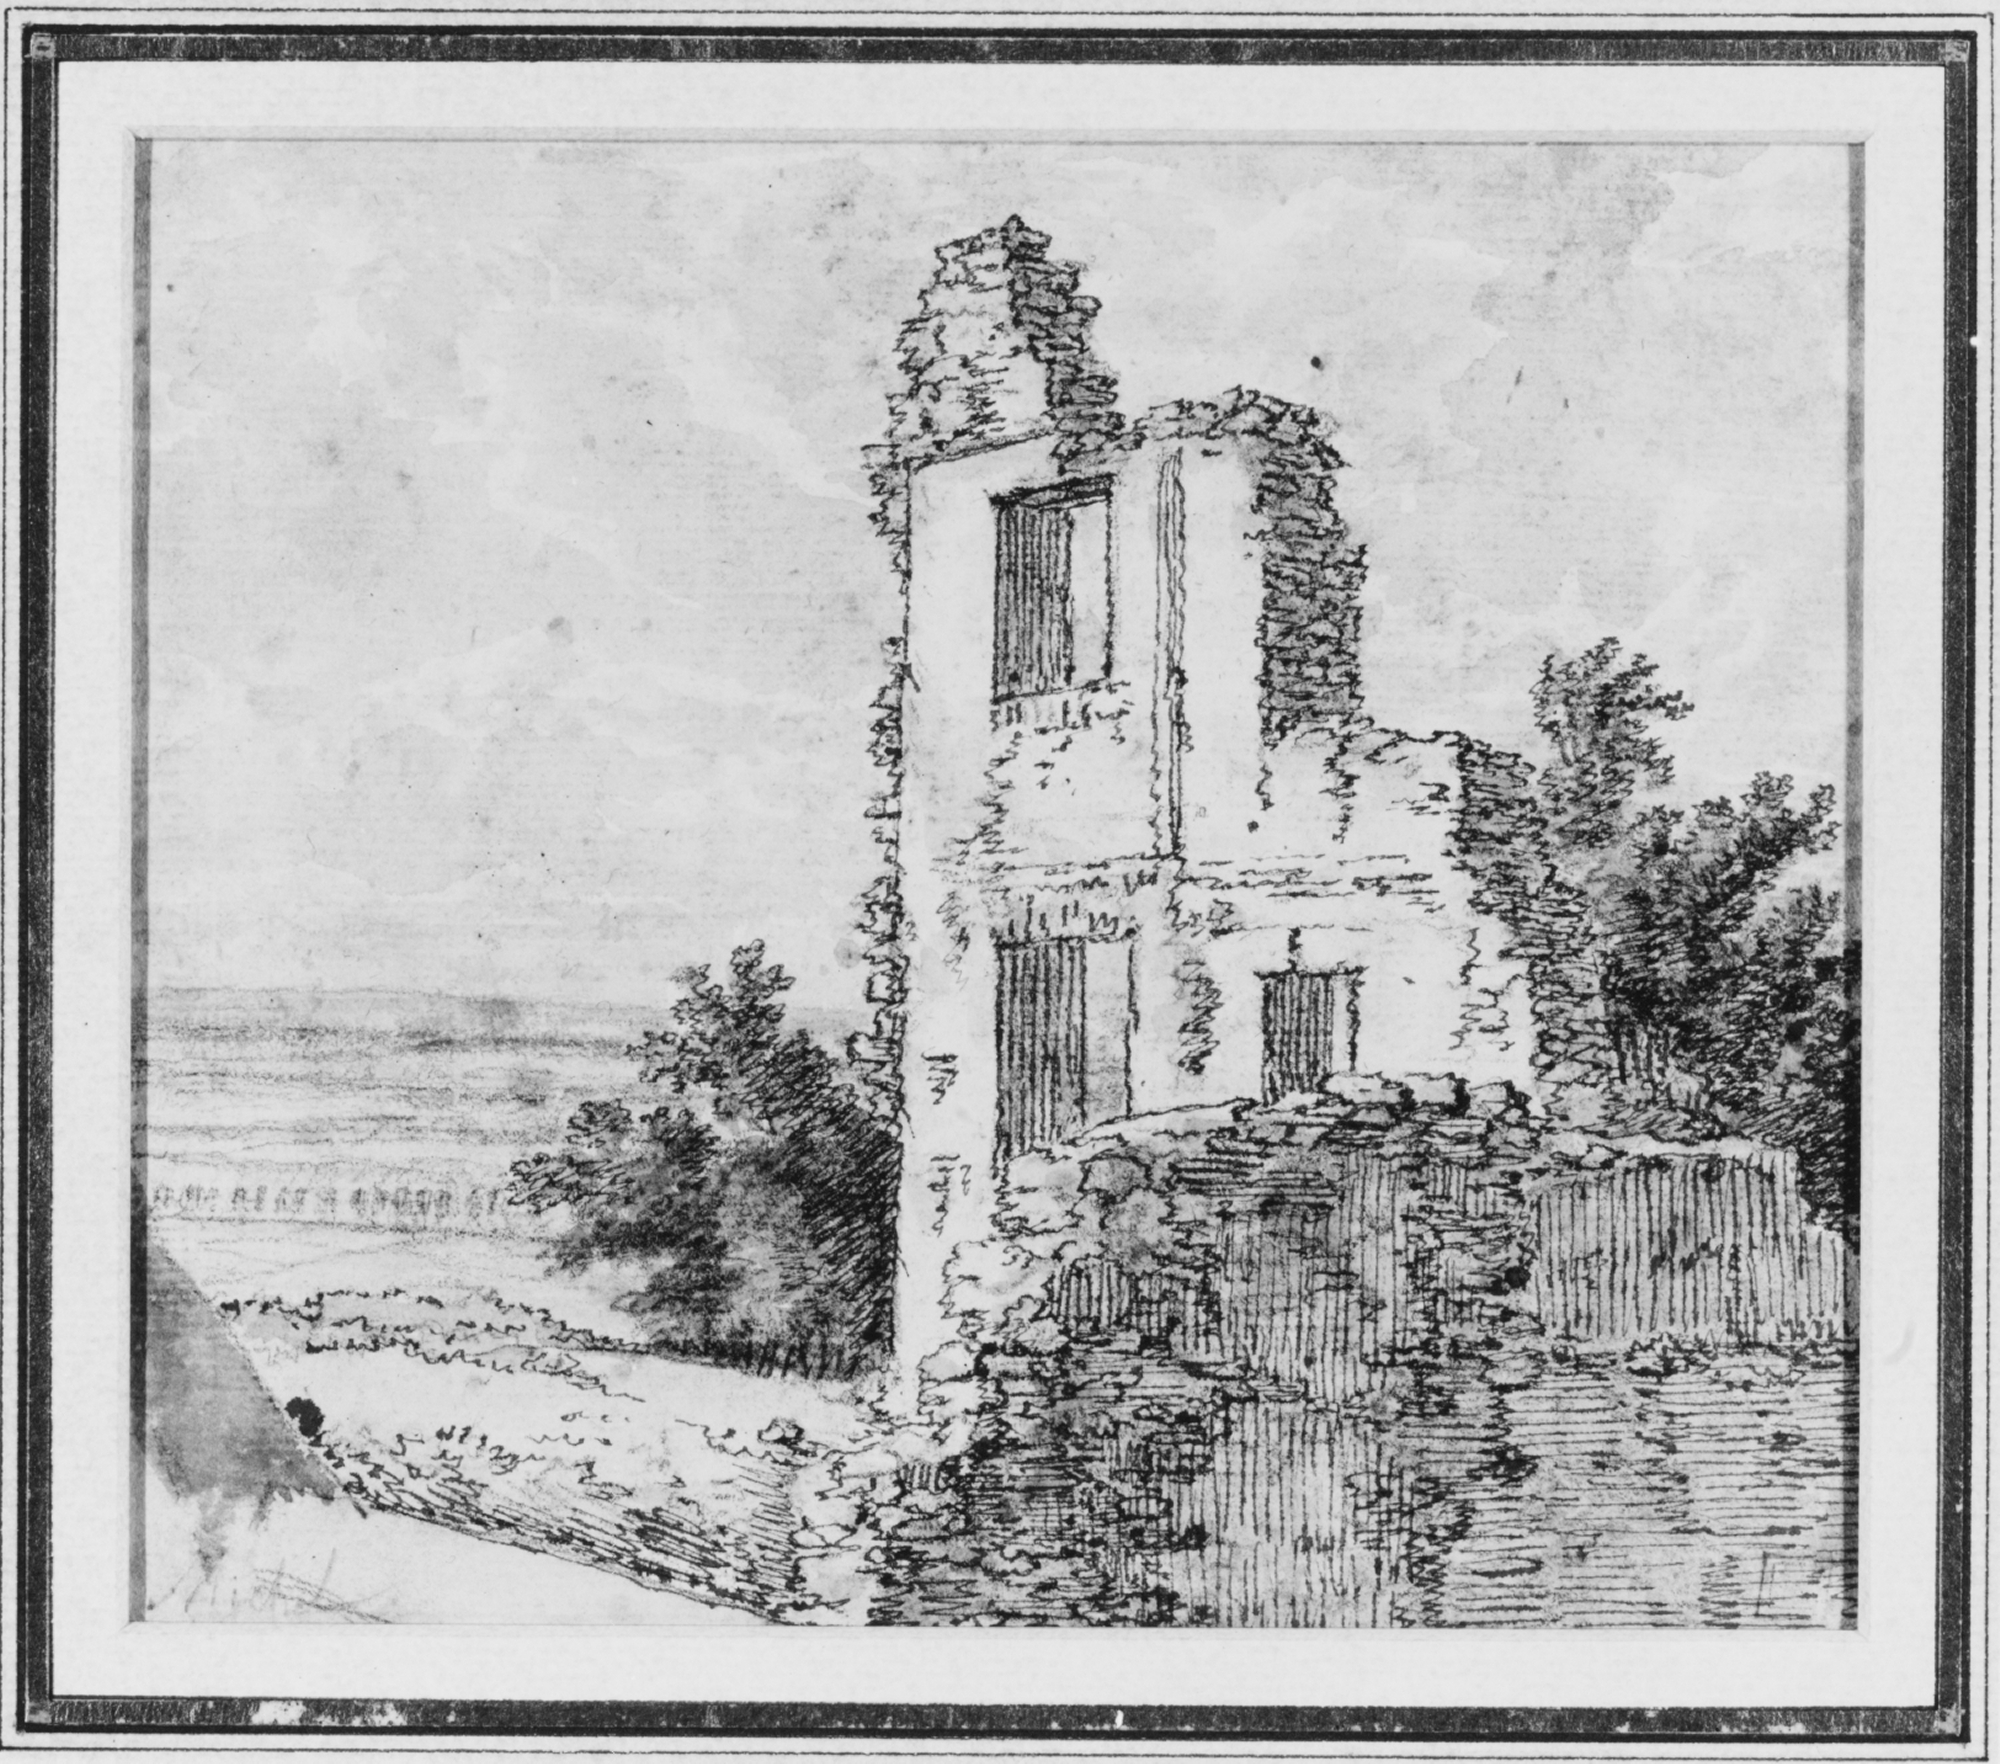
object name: drawing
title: An Allée of Trees in a Park (recto); The Ruins of a Building on a Hill (verso)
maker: georges michel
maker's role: artist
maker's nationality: french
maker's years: 1763-1843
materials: chalk, ink, watercolor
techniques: pen, wash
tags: buildings,ruins,trees